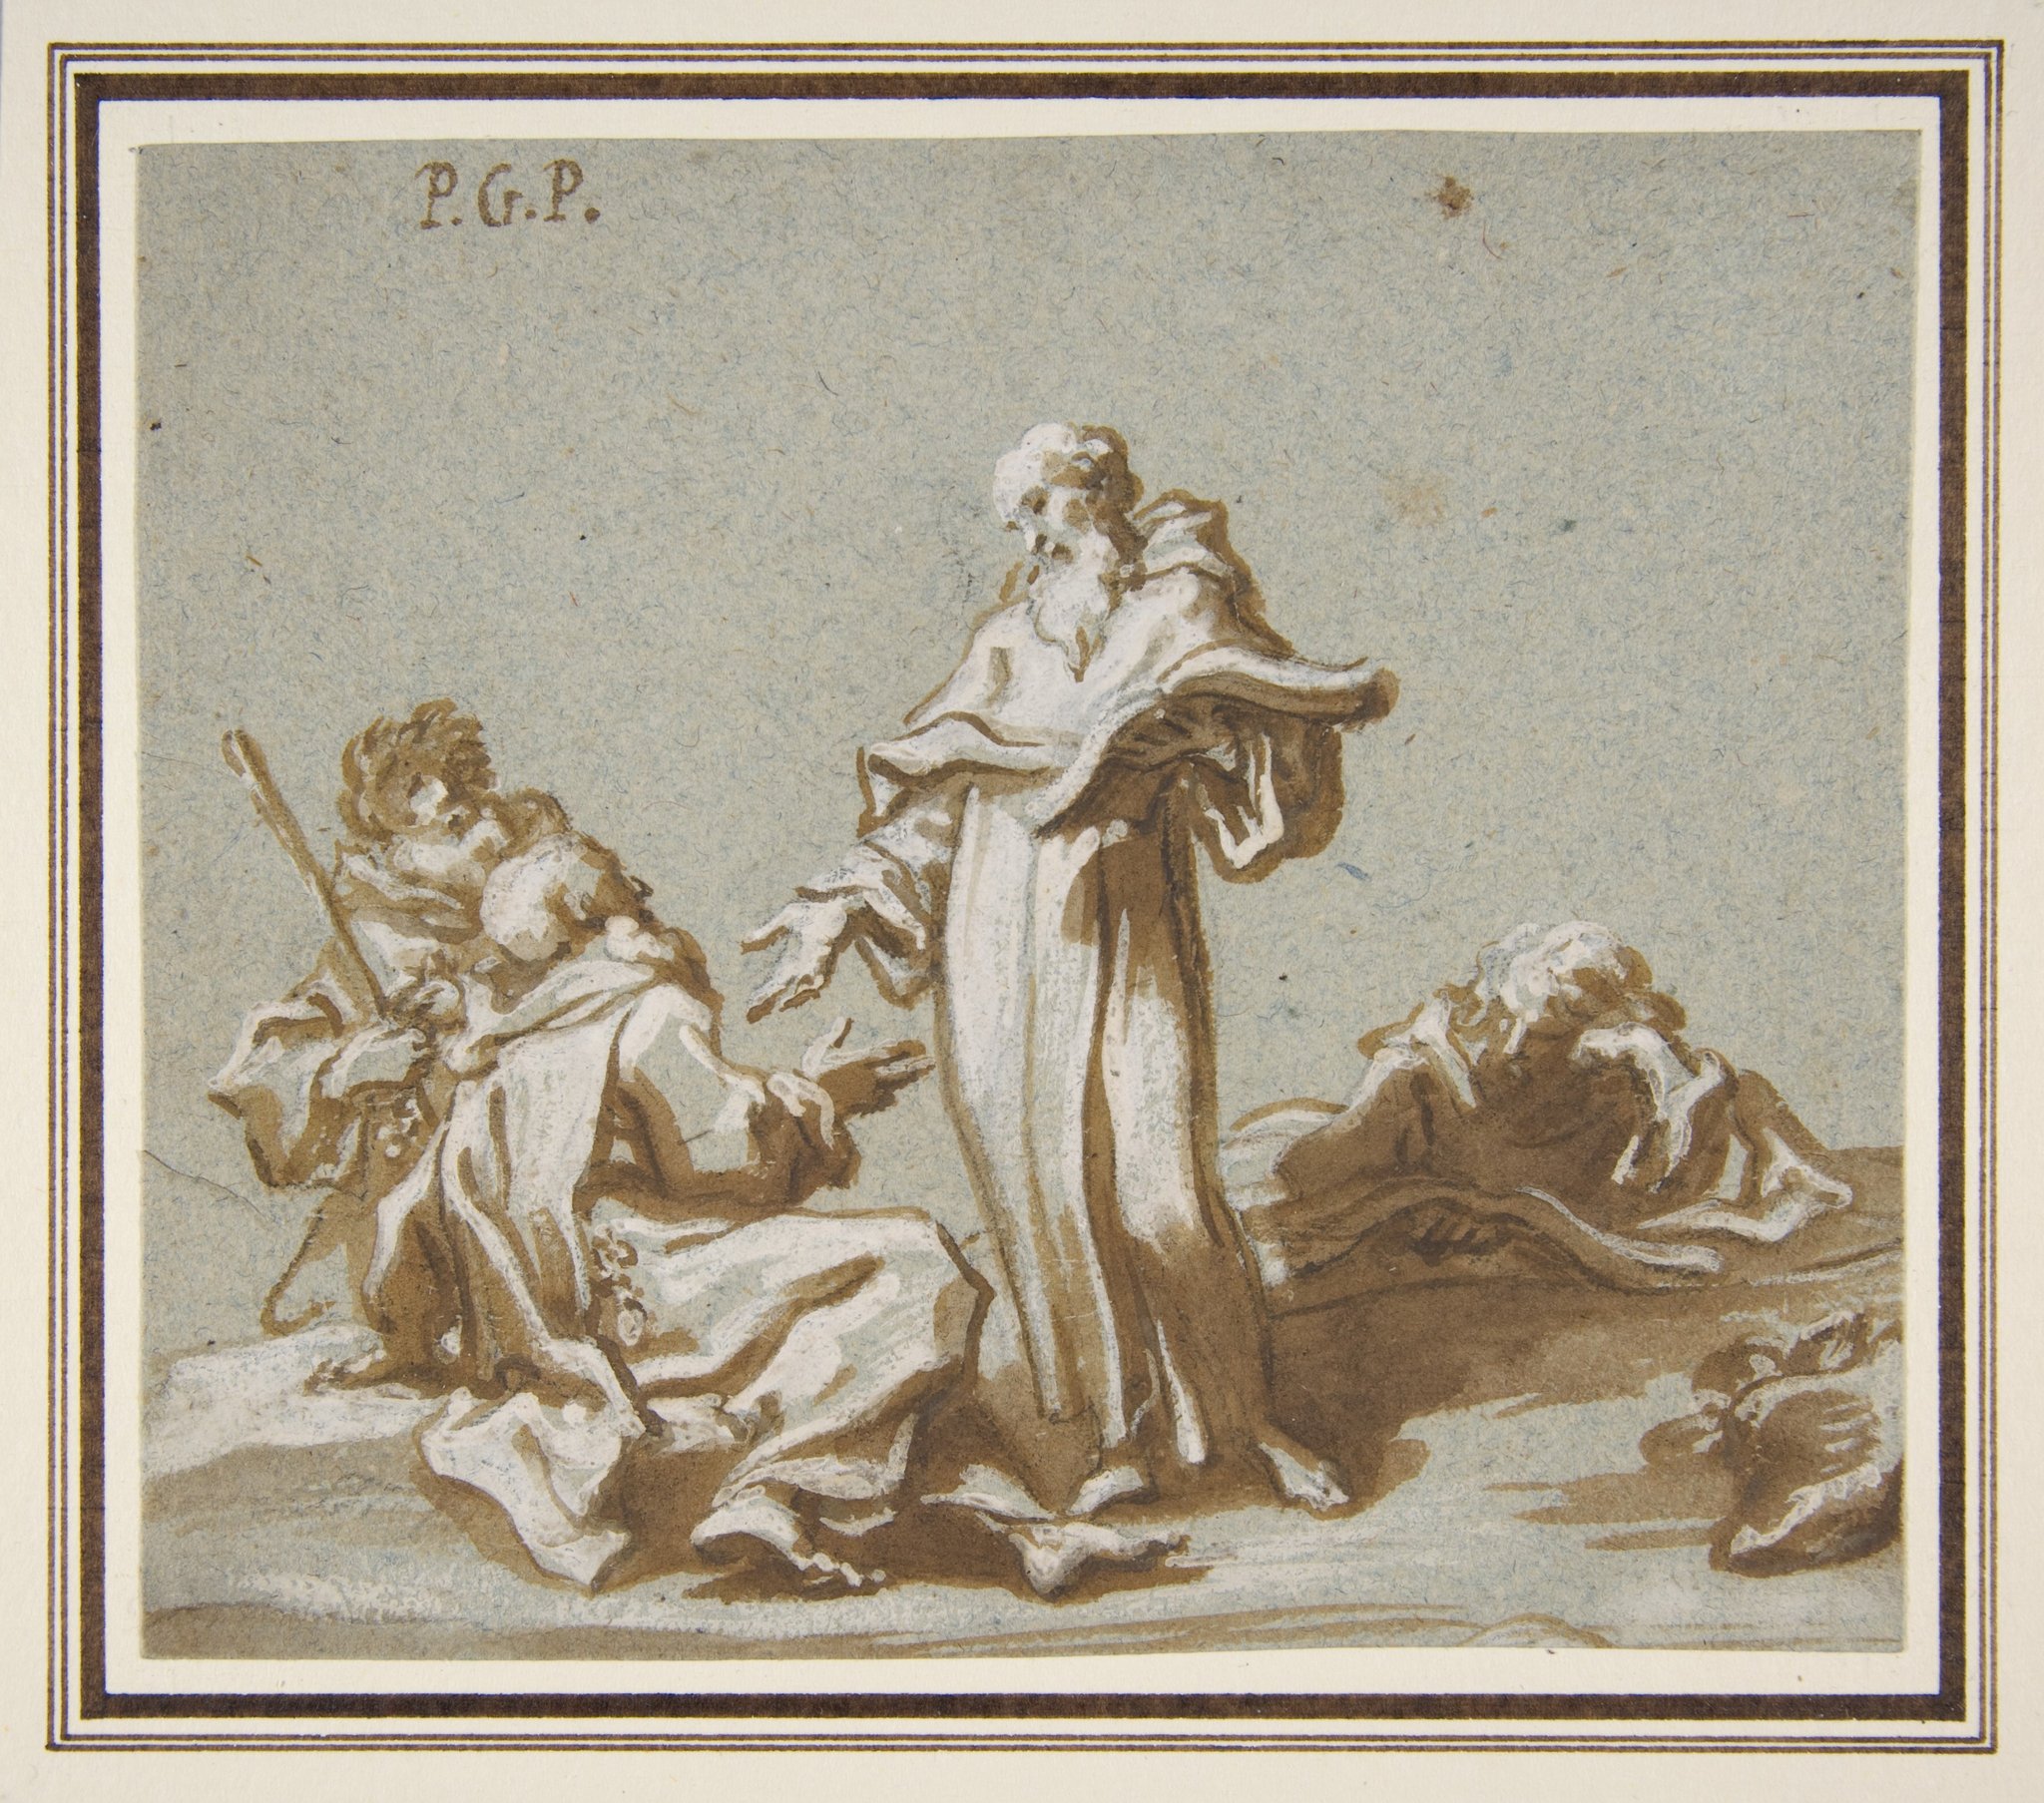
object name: drawing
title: Scene with Four Figures of Monks Discoursing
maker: paolo gerolamo piola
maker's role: artist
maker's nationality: italian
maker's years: 1666-1724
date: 1666-1724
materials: charcoal, paper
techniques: brush, highlighting, wash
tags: monks